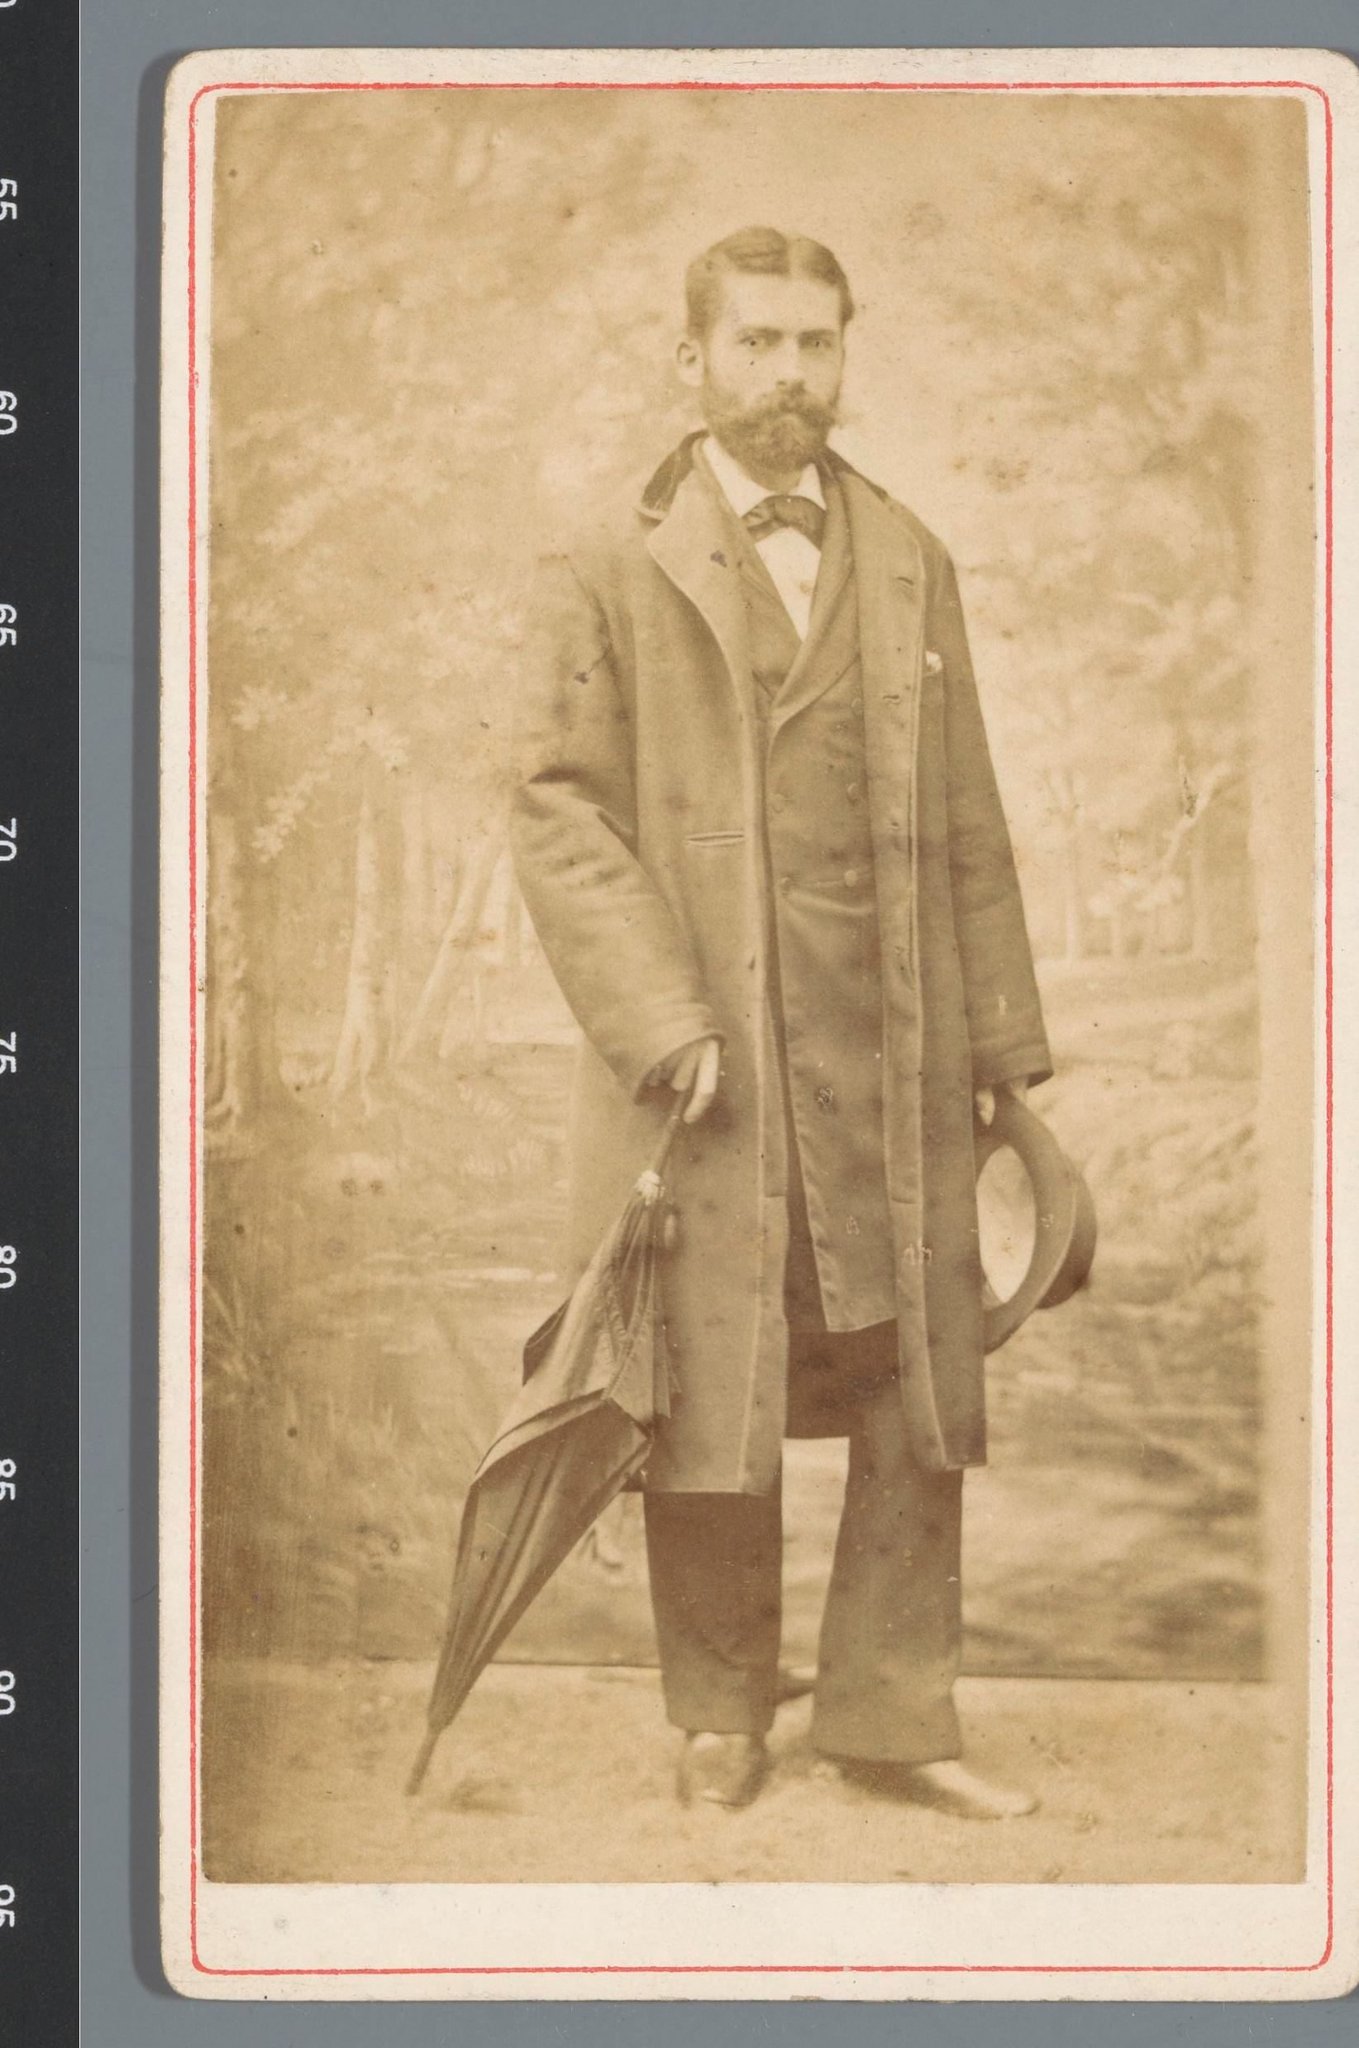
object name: carte de visite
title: Portret van een onbekende man met een hoed en een paraplu in de hand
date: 1855-1875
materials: cardboard, paper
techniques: albumen print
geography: amsterdam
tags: adult man, historical persons, head-gear: hat, umbrella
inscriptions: stamp: ‘Photographisch Atelier/ van/ C. Hünerjäger & Co./ Spiegelstraat bij de Kerkstraat C C 42/ AMSTERDAM’